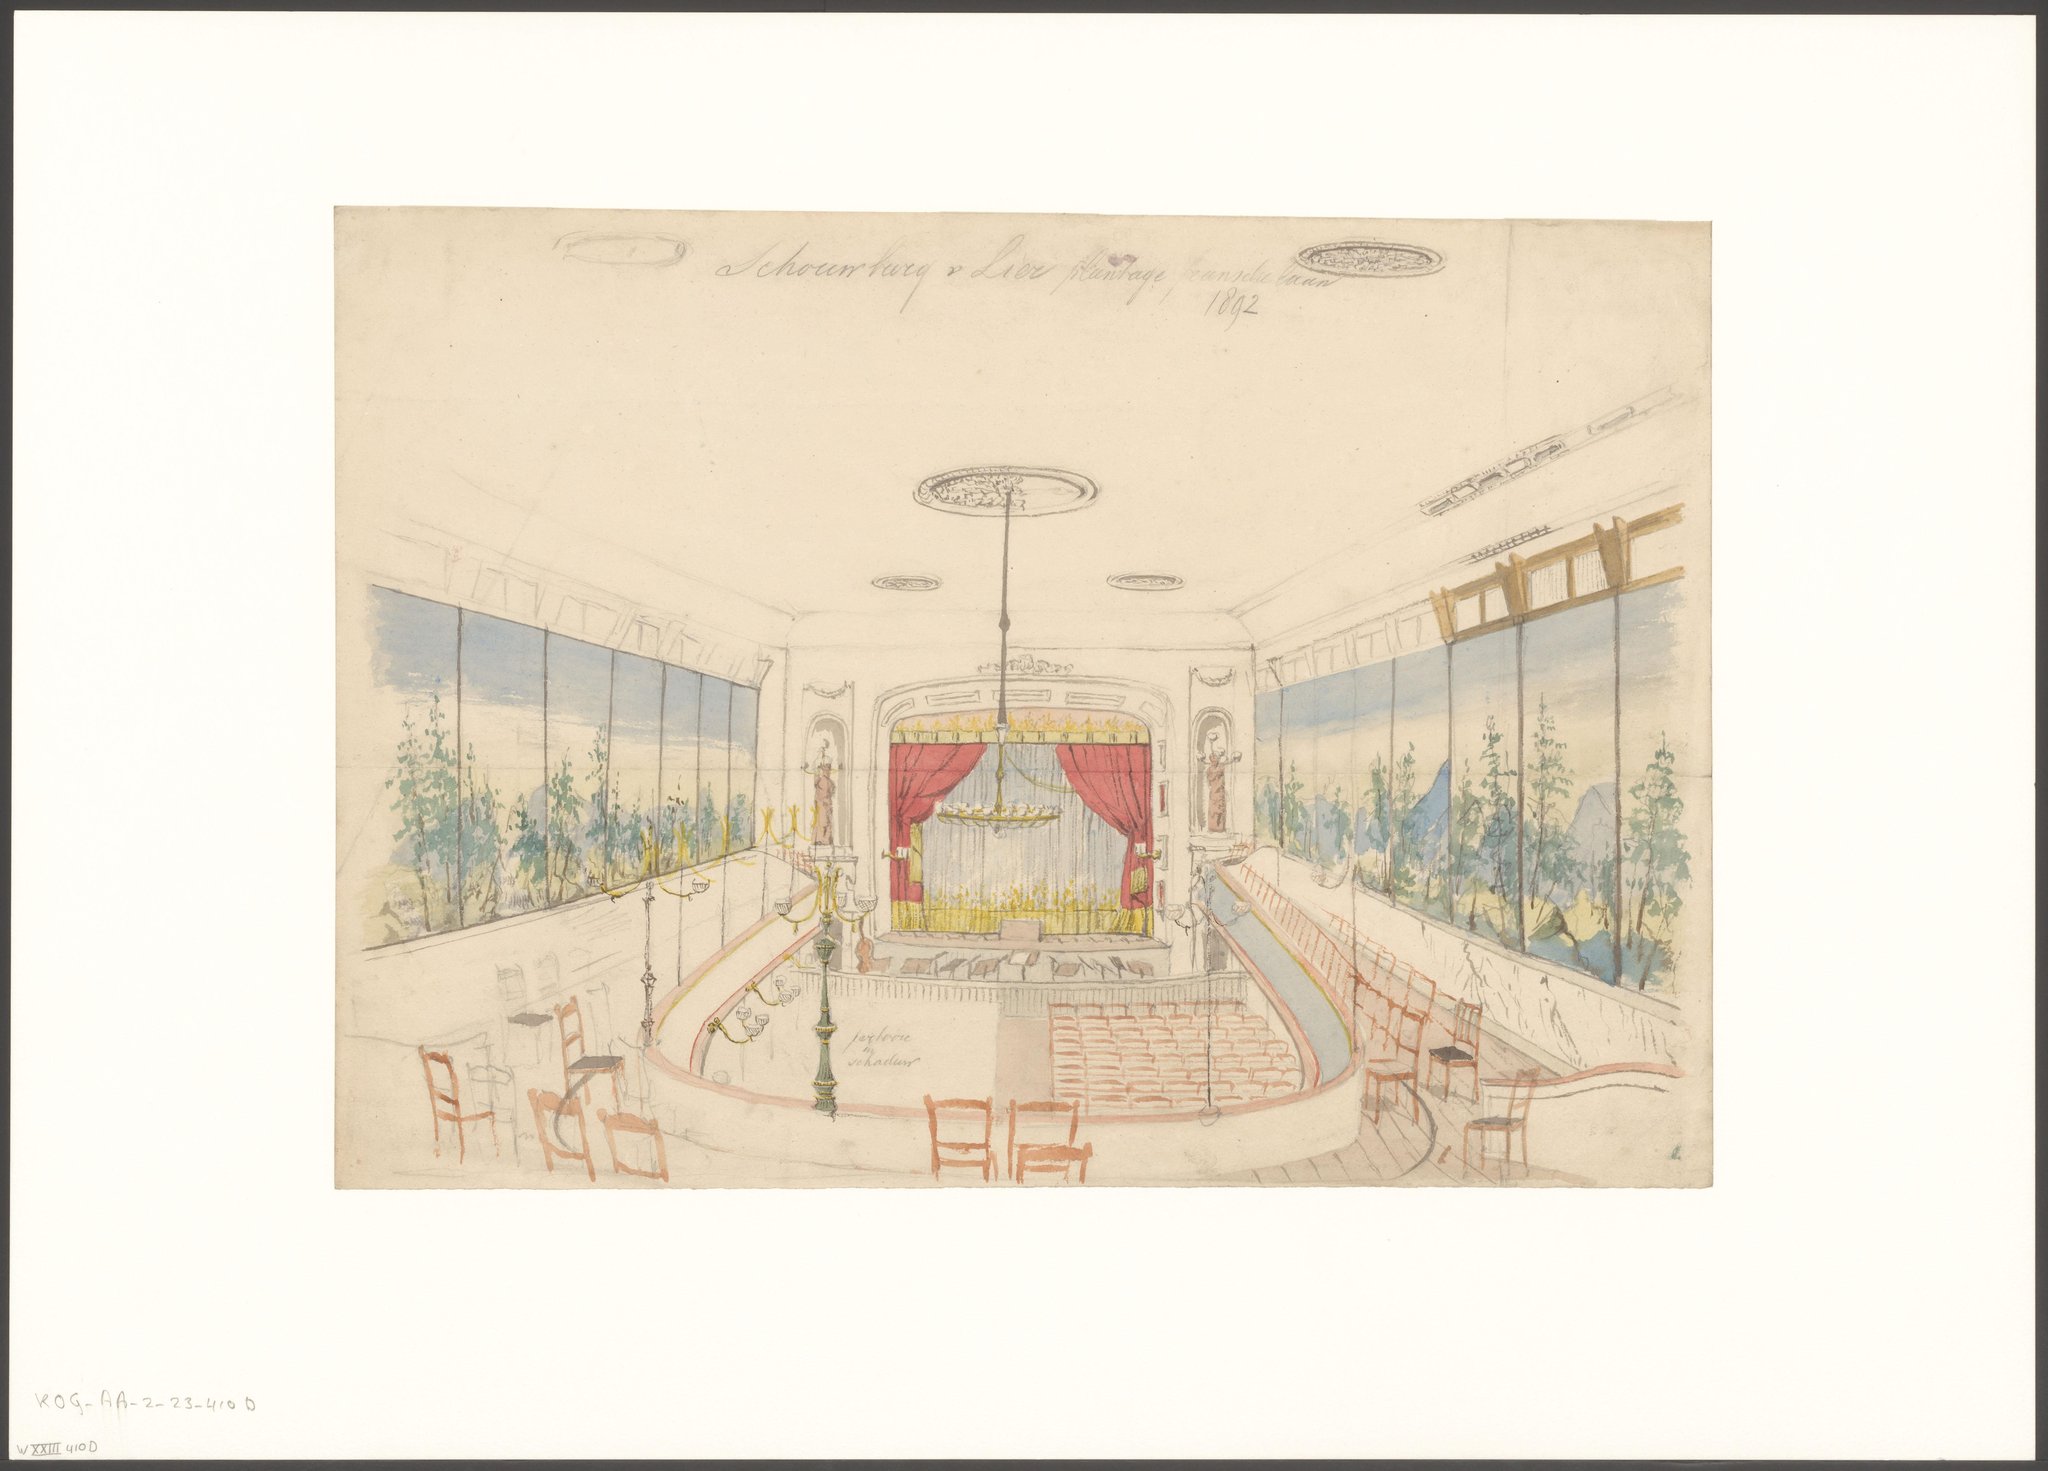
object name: drawing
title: Interieur van de Schouwburg van Lier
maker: johan george lodewijk rieke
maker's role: draughtsman, print maker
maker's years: 1817-1898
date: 1892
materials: paper, pencil, watercolor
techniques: brush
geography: amsterdam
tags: city-view in general; 'veduta', theatre, theatrical performance, the stage and its equipment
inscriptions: inscription: ‘Schouwburg v Lier (...) parterre in schaduw’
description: Tekening binnen de Atlas Van Eck ingedeeld op wijknummer 23.